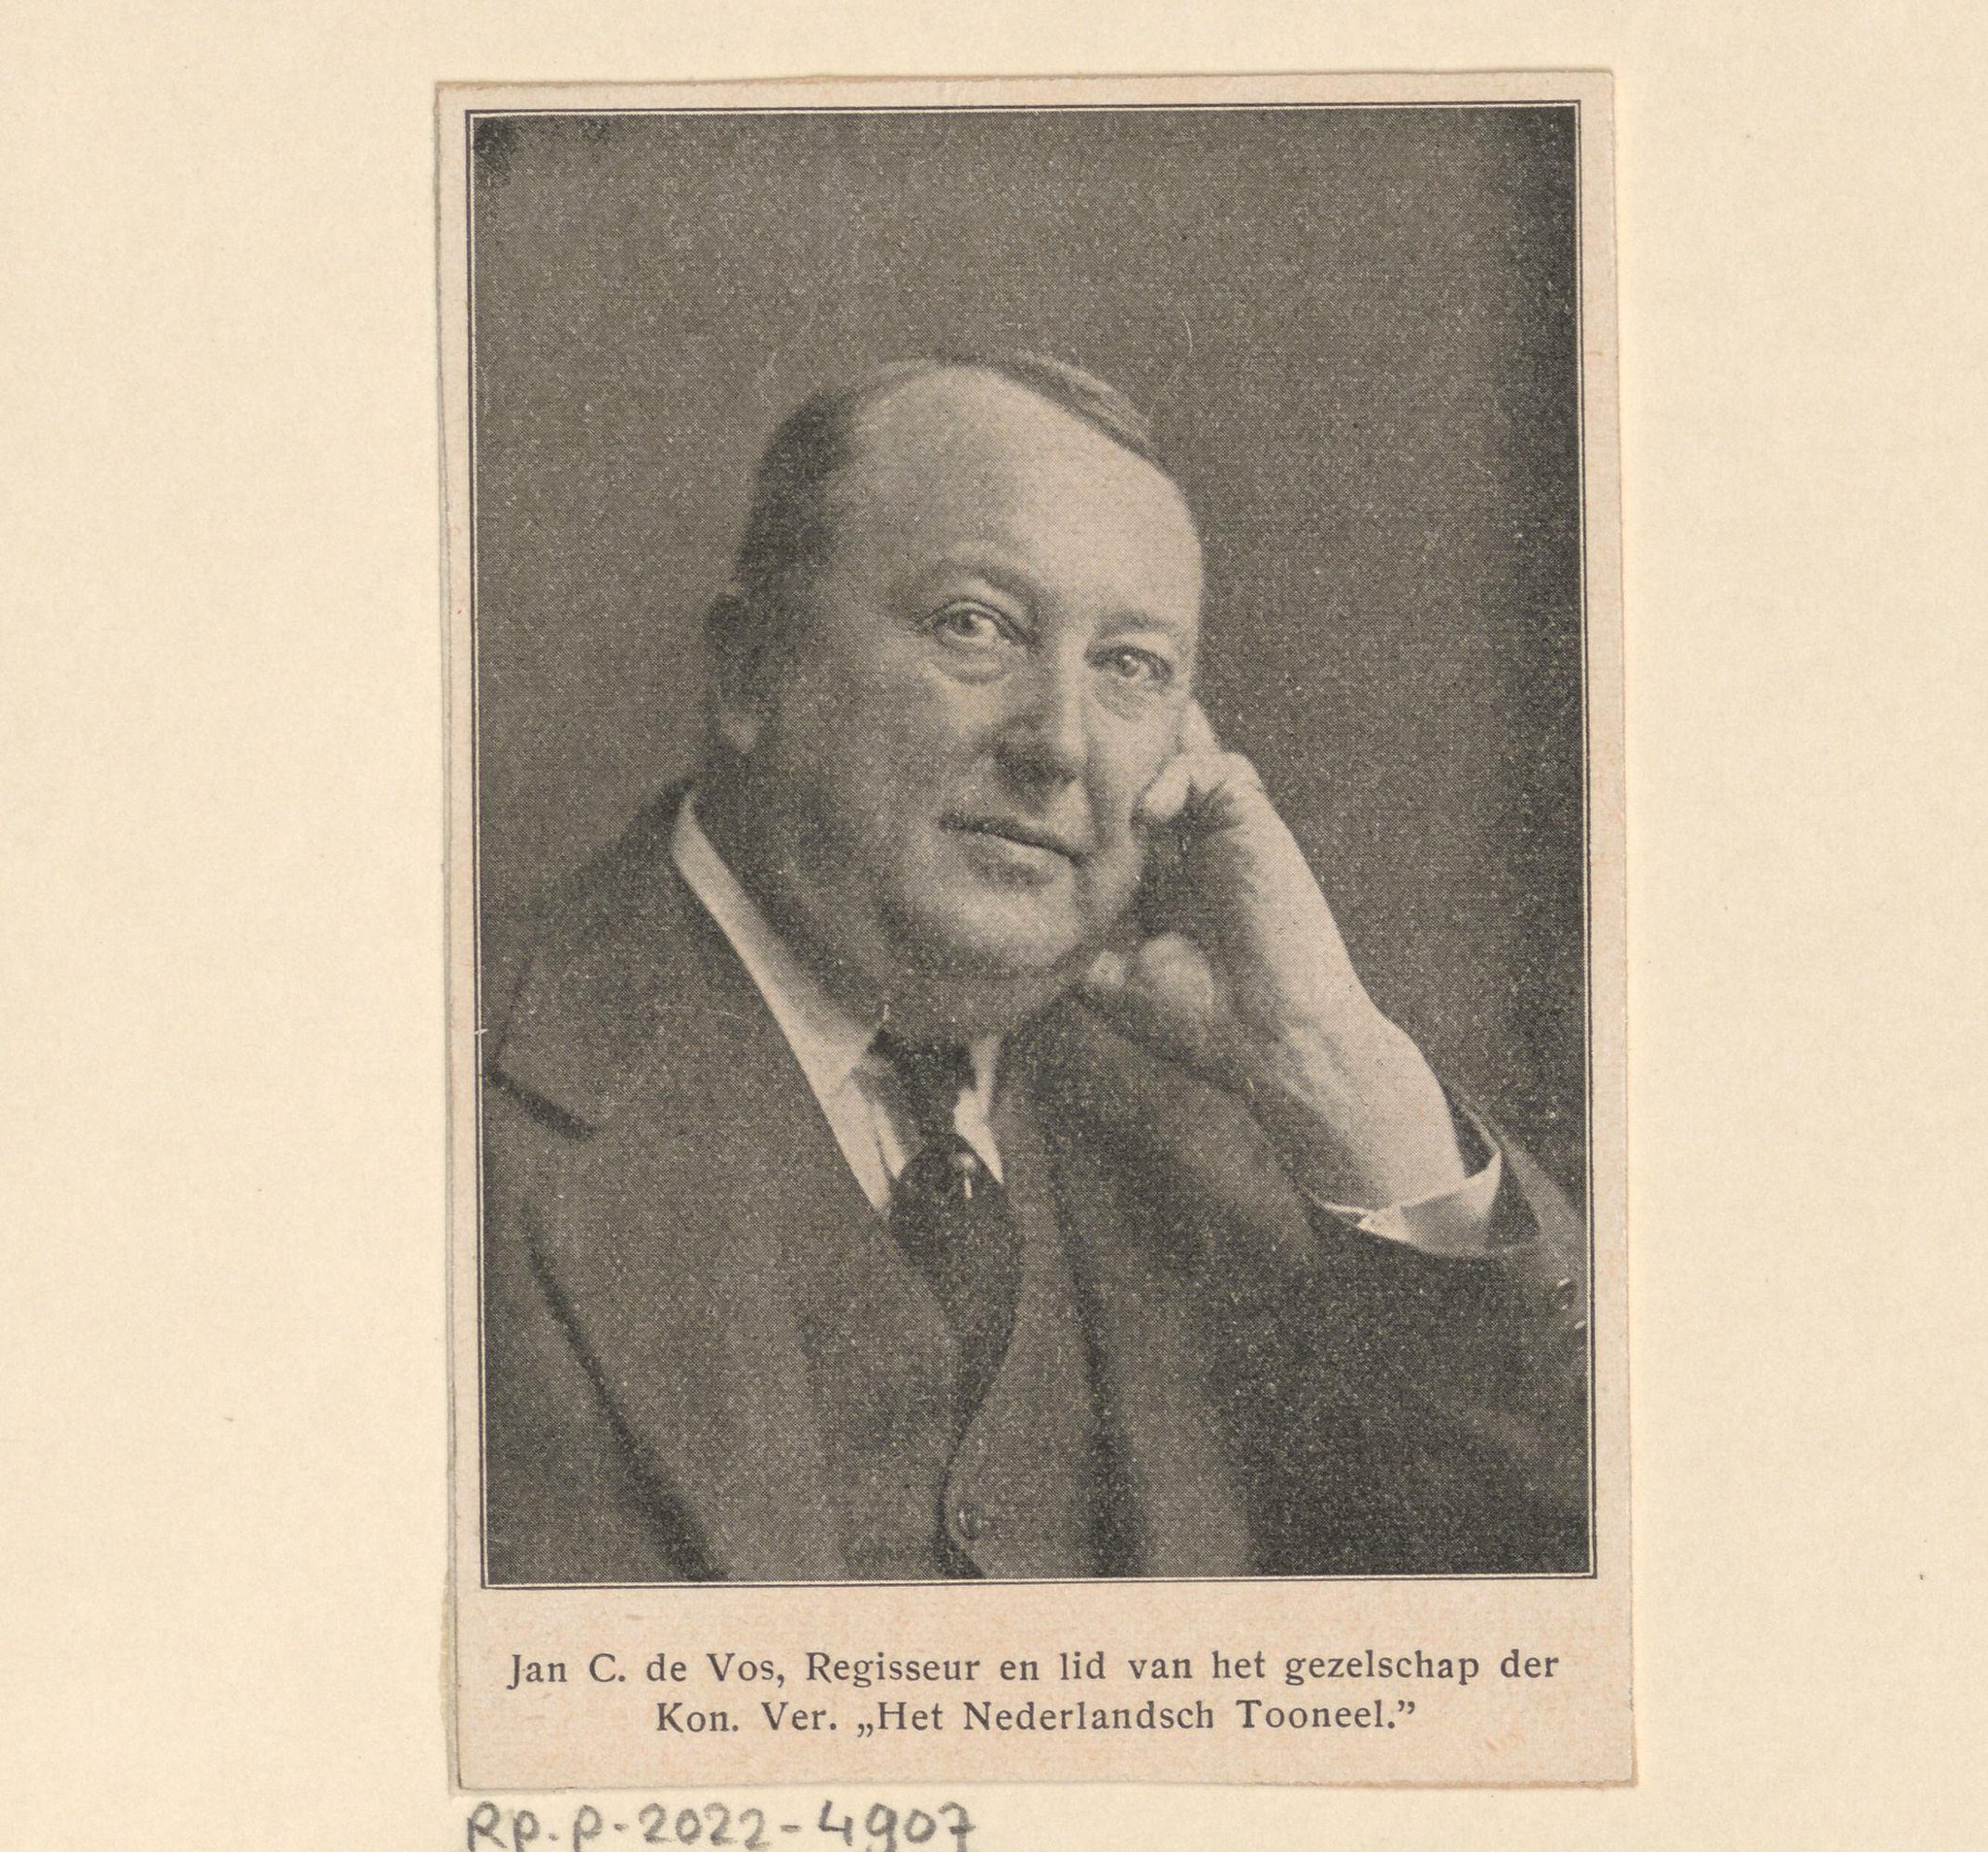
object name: photomechanical print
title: Portret van Jan Cornelis de Vos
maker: Anonymous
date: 1901-1918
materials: paper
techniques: autotype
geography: netherlands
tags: portrait of artiste (dancer, actor, etc.), director, producer ~ the stage, historical persons